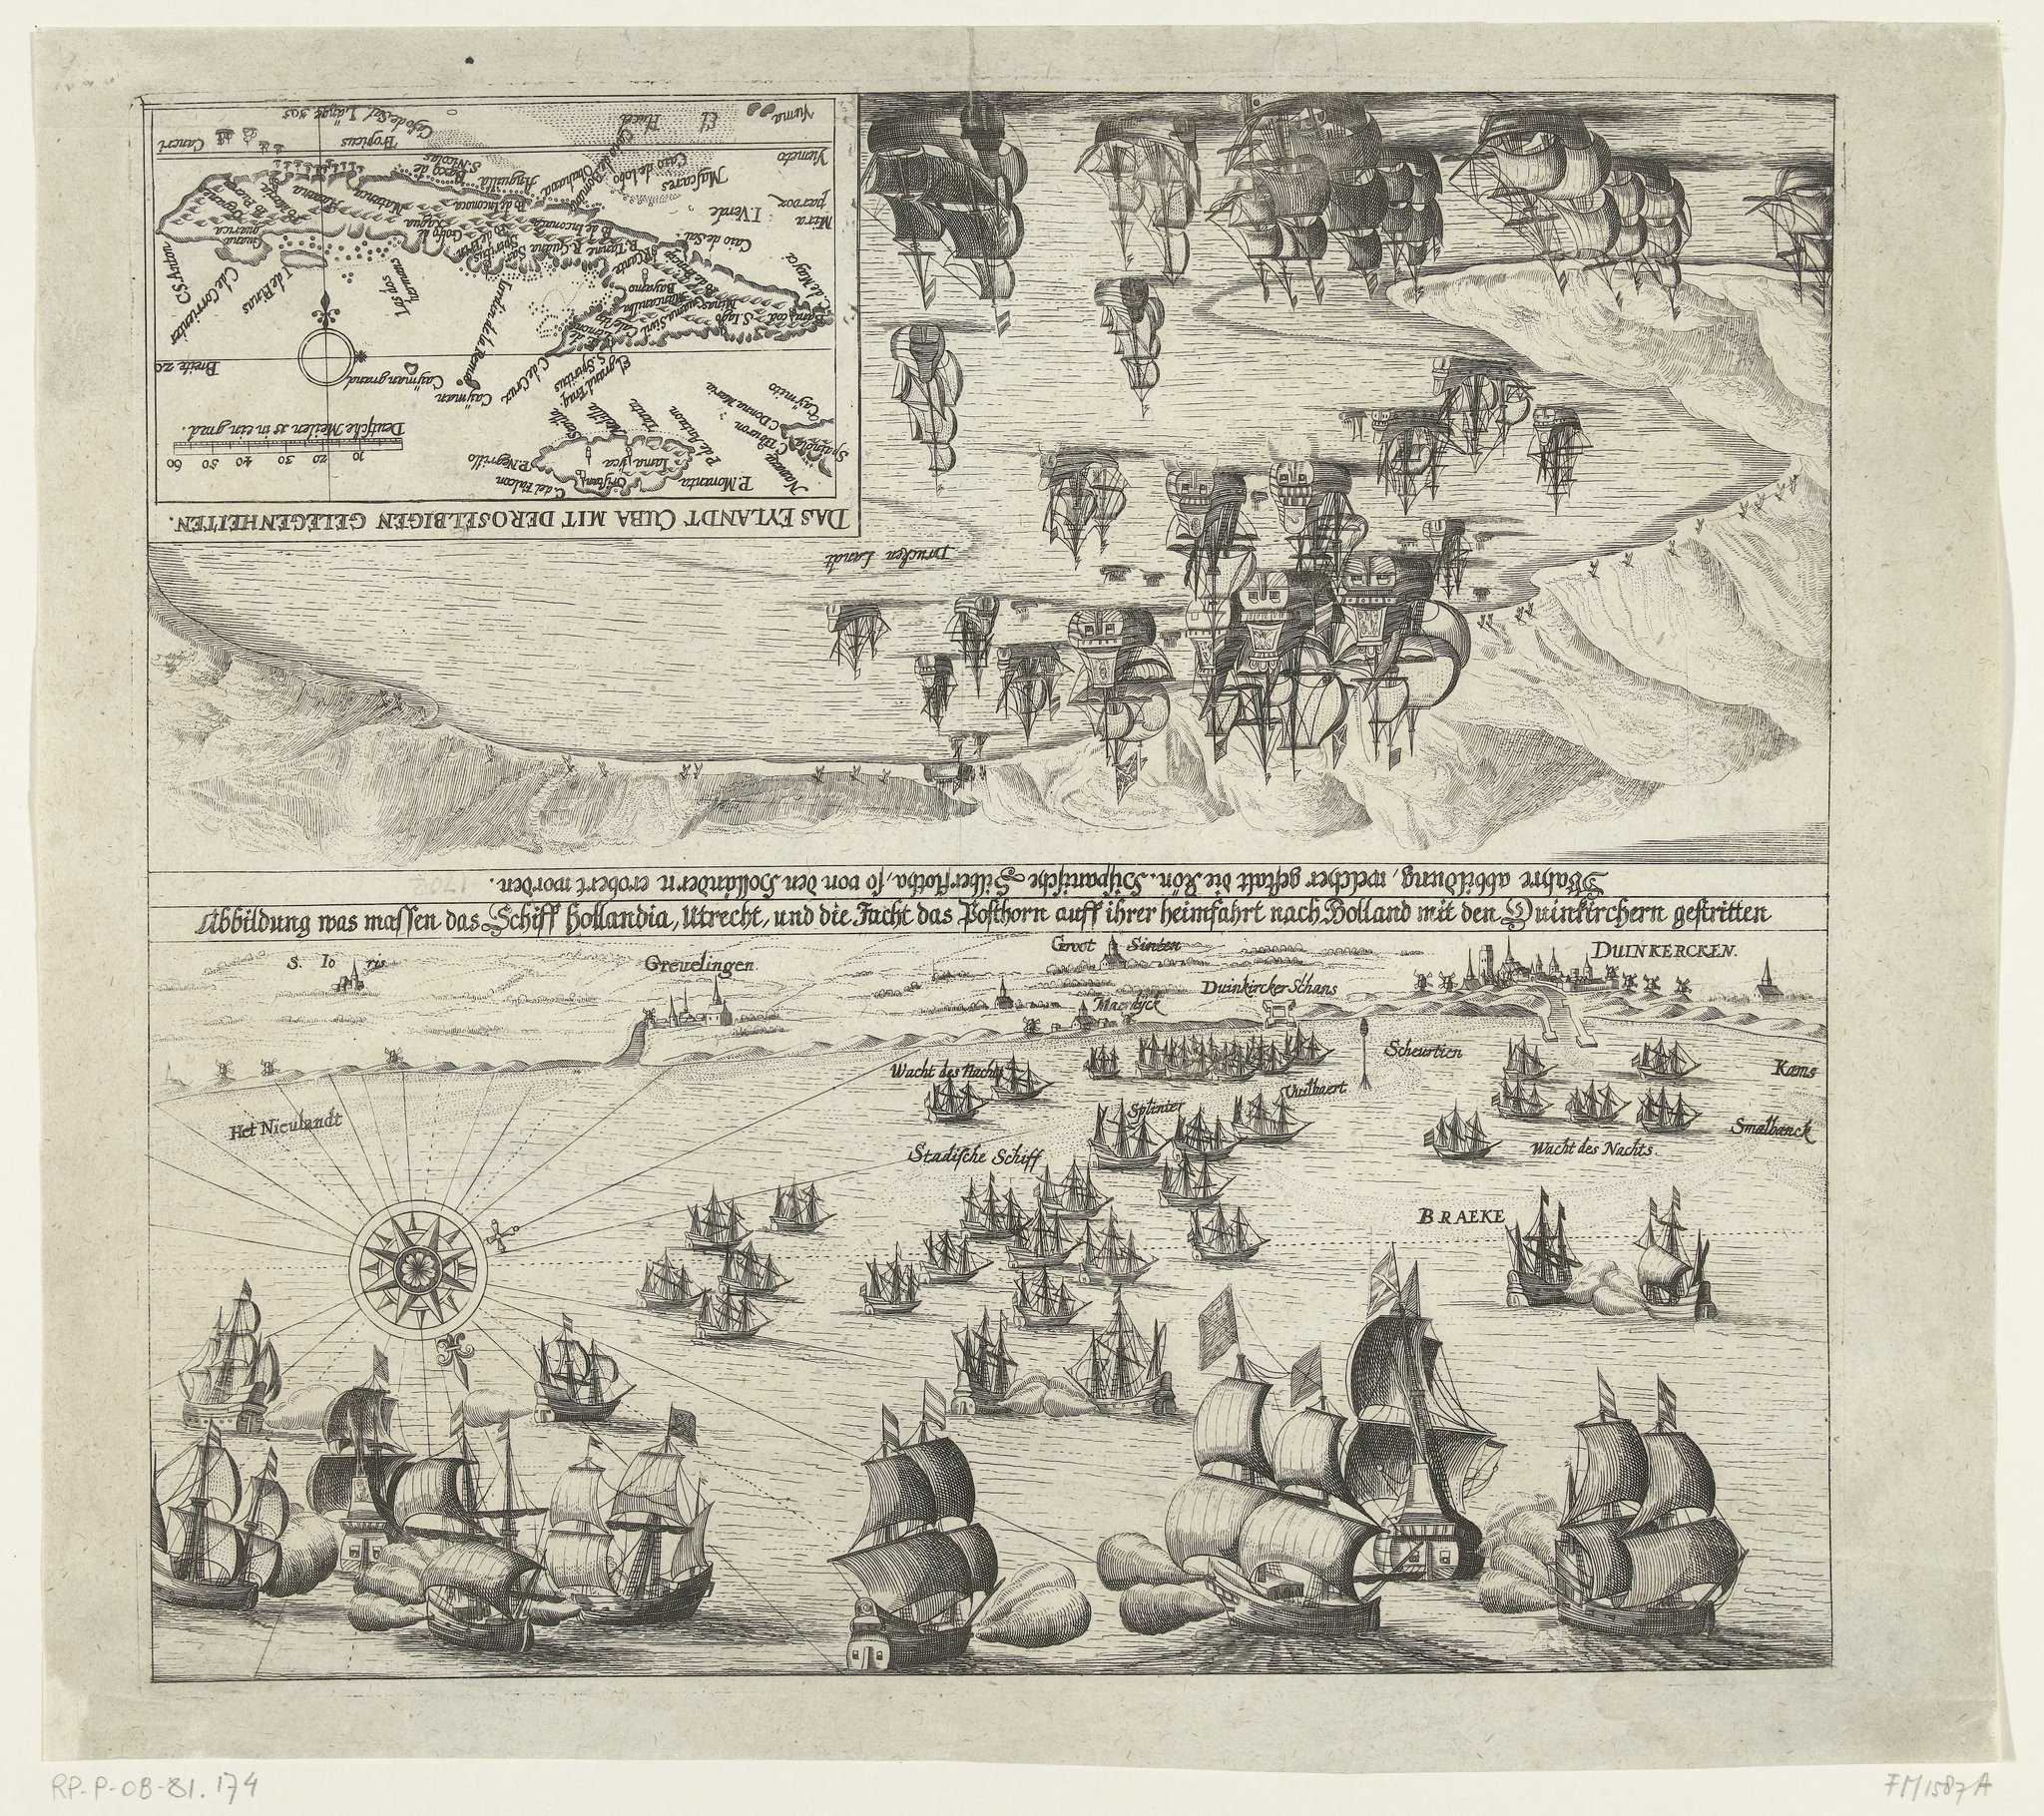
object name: print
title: Abbildung was massen das Schiff Hollandia, Utrecht, und die Jacht das Posthorn auff ihrer heimfahrt nach Holland mit den Duinkirchern gestritten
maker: Anonymous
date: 1628-1649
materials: paper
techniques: etching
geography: germany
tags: delfshaven, pirate, corsair, buccaneer, battle (+ naval force), capture of the spanish treasure fleet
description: Blad met twee afbeeldingen. Onder gevechten tussen schepen van de Staatse vloot onder Piet Hein, waaronder de Hollandia, de Utrecht en de Posthoorn, en zeerovers afkomstig uit Duinkerken, 1628. Op dezelfde plaat andersom bovenaan (om losgeknipt te worden) de verovering van de Spaanse zilvervloot in de baai van Matanca door Piet Hein, 8 september 1628.